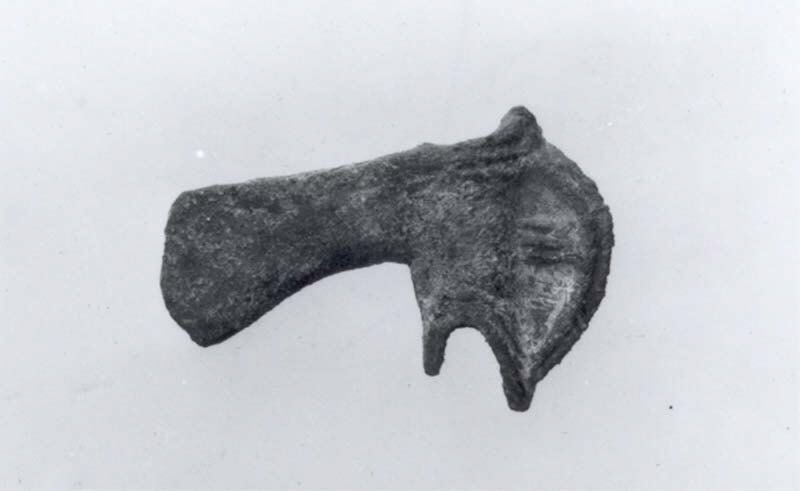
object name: axe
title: Minature axe head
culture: iranian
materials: bronze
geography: iran, luristan